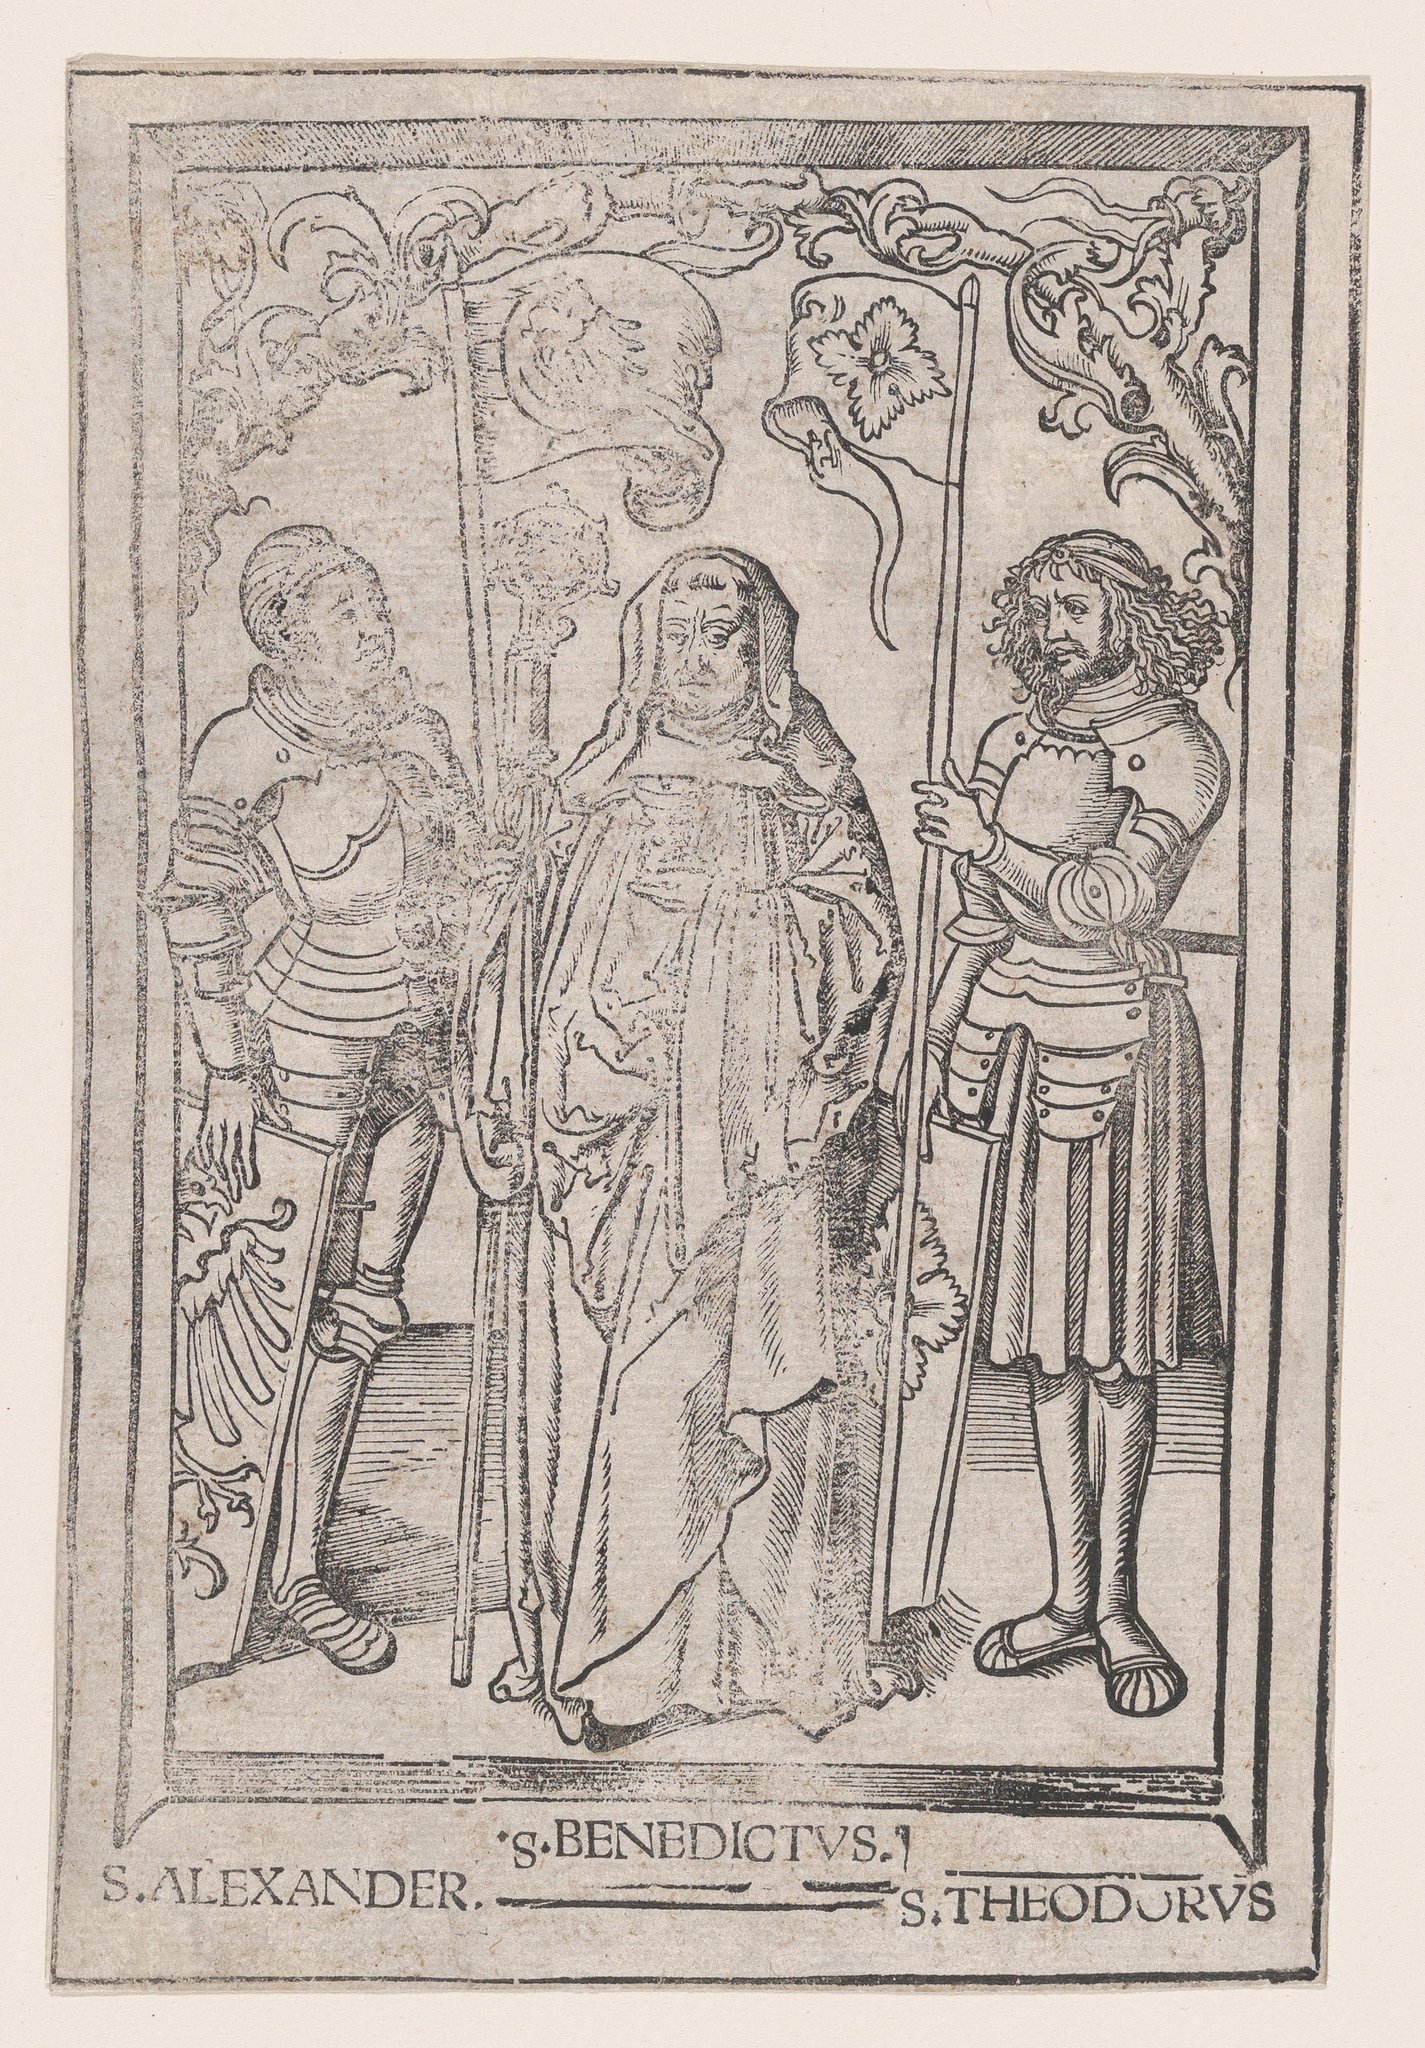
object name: print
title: Saints Alexander and Theodore flanking Saint Benedict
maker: anonymous, italian, 16th century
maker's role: artist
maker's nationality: italian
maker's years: 1500-1600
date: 1500-1550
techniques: woodcut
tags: saints